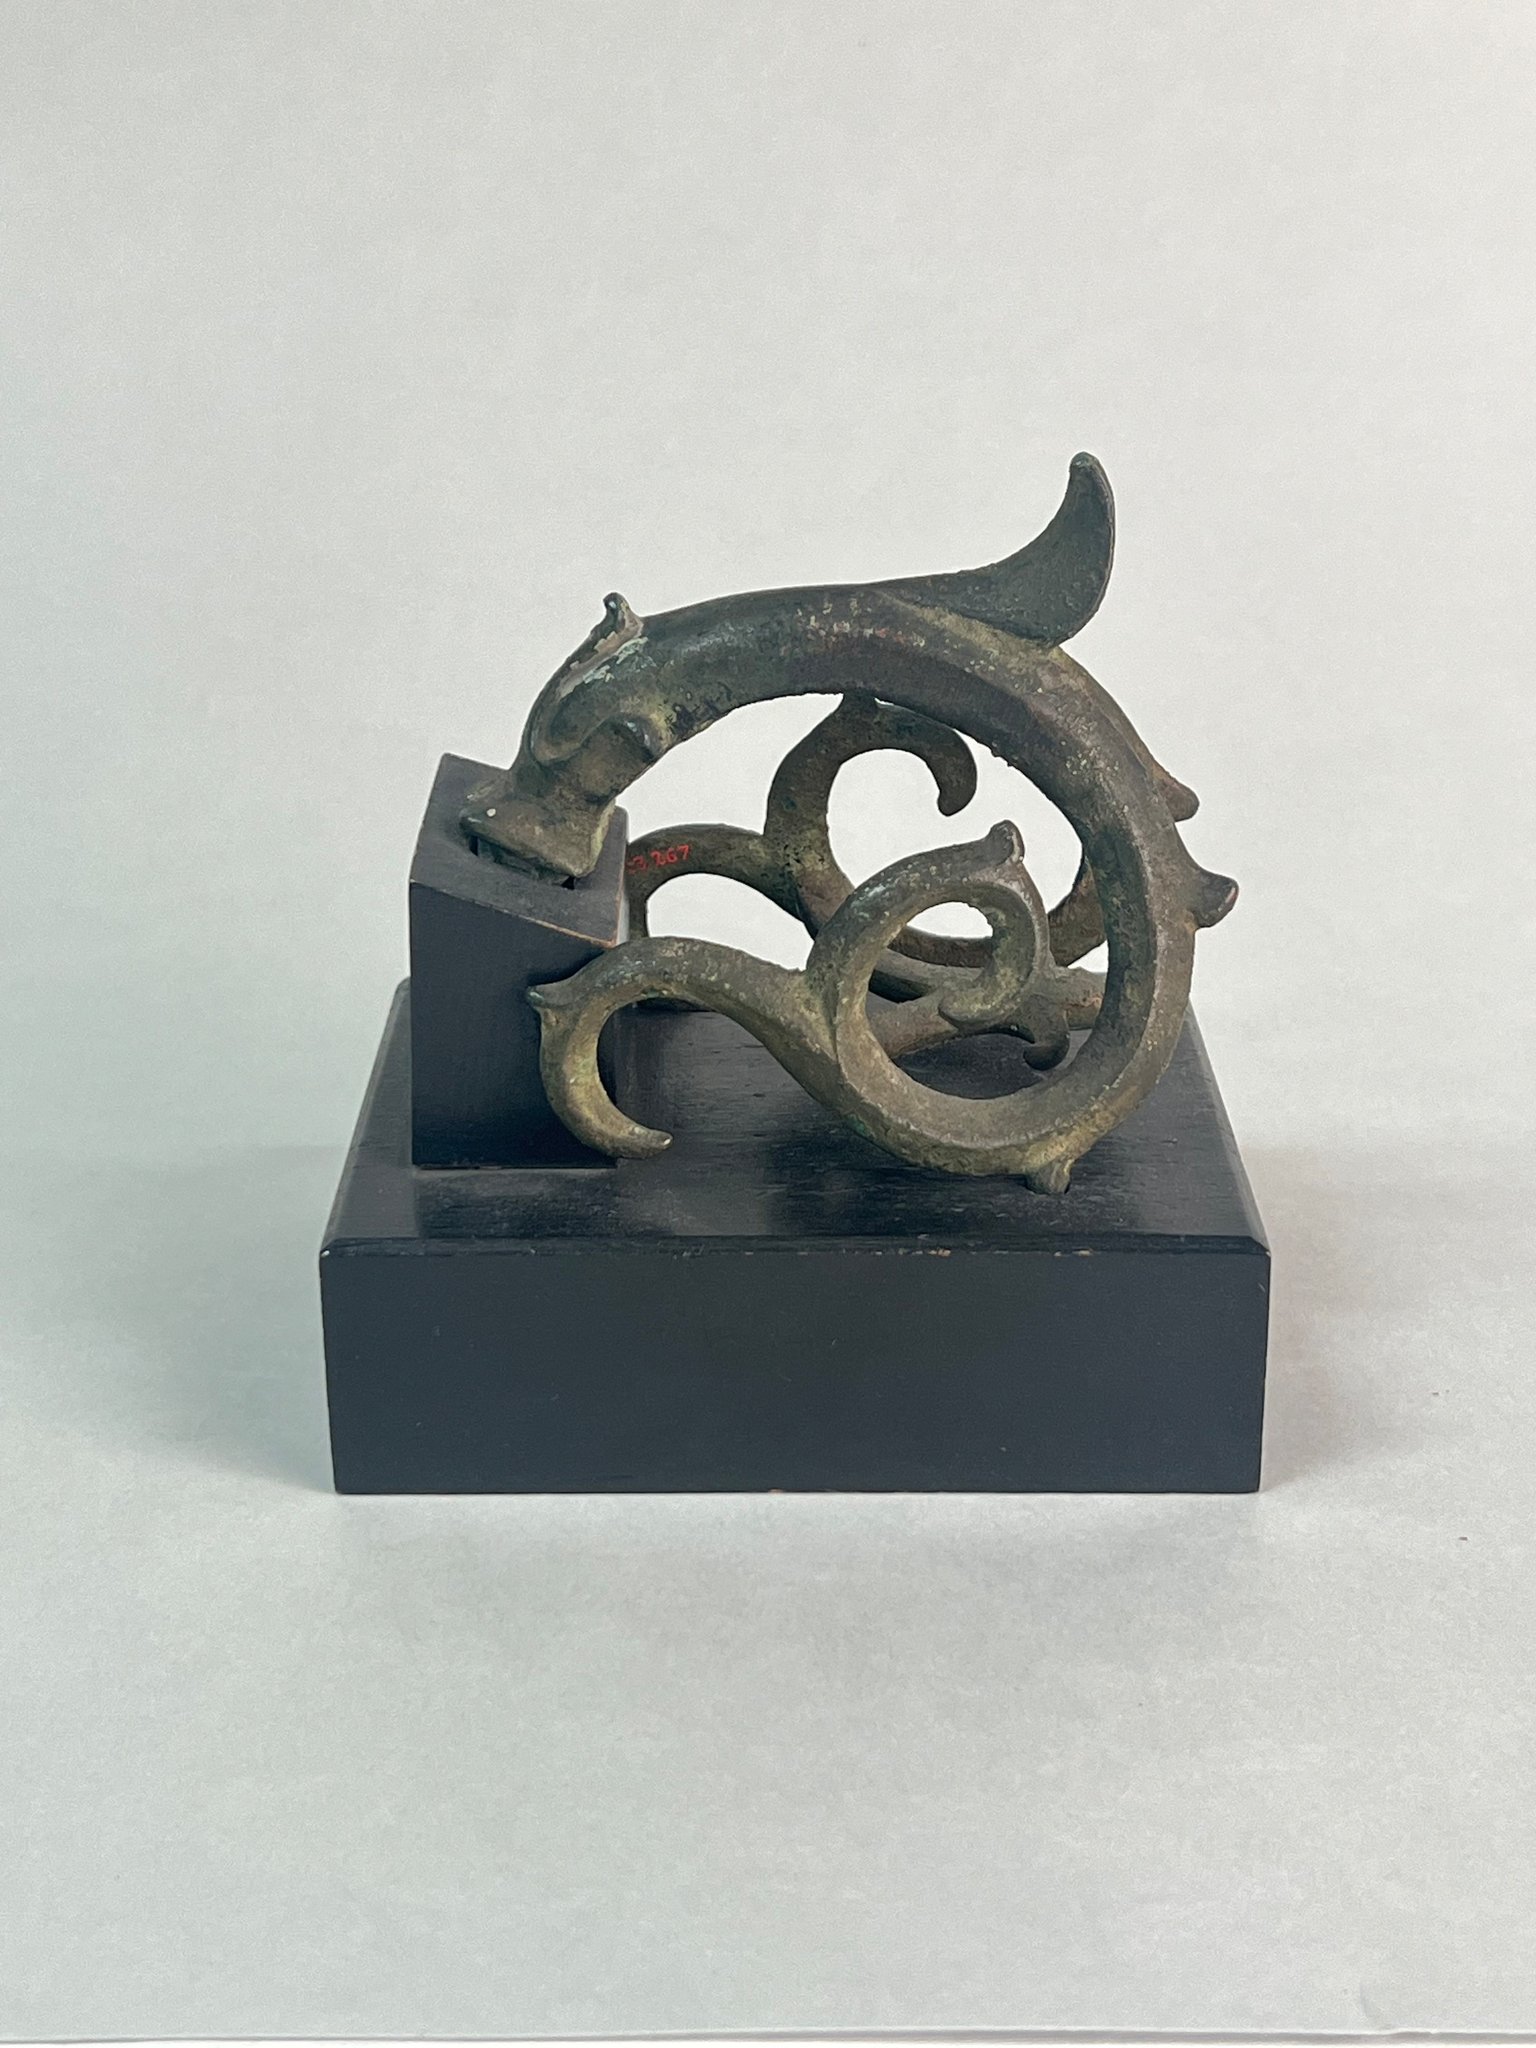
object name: ornament detail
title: Detail of Ornament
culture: chinese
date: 1801-1900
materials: bronze